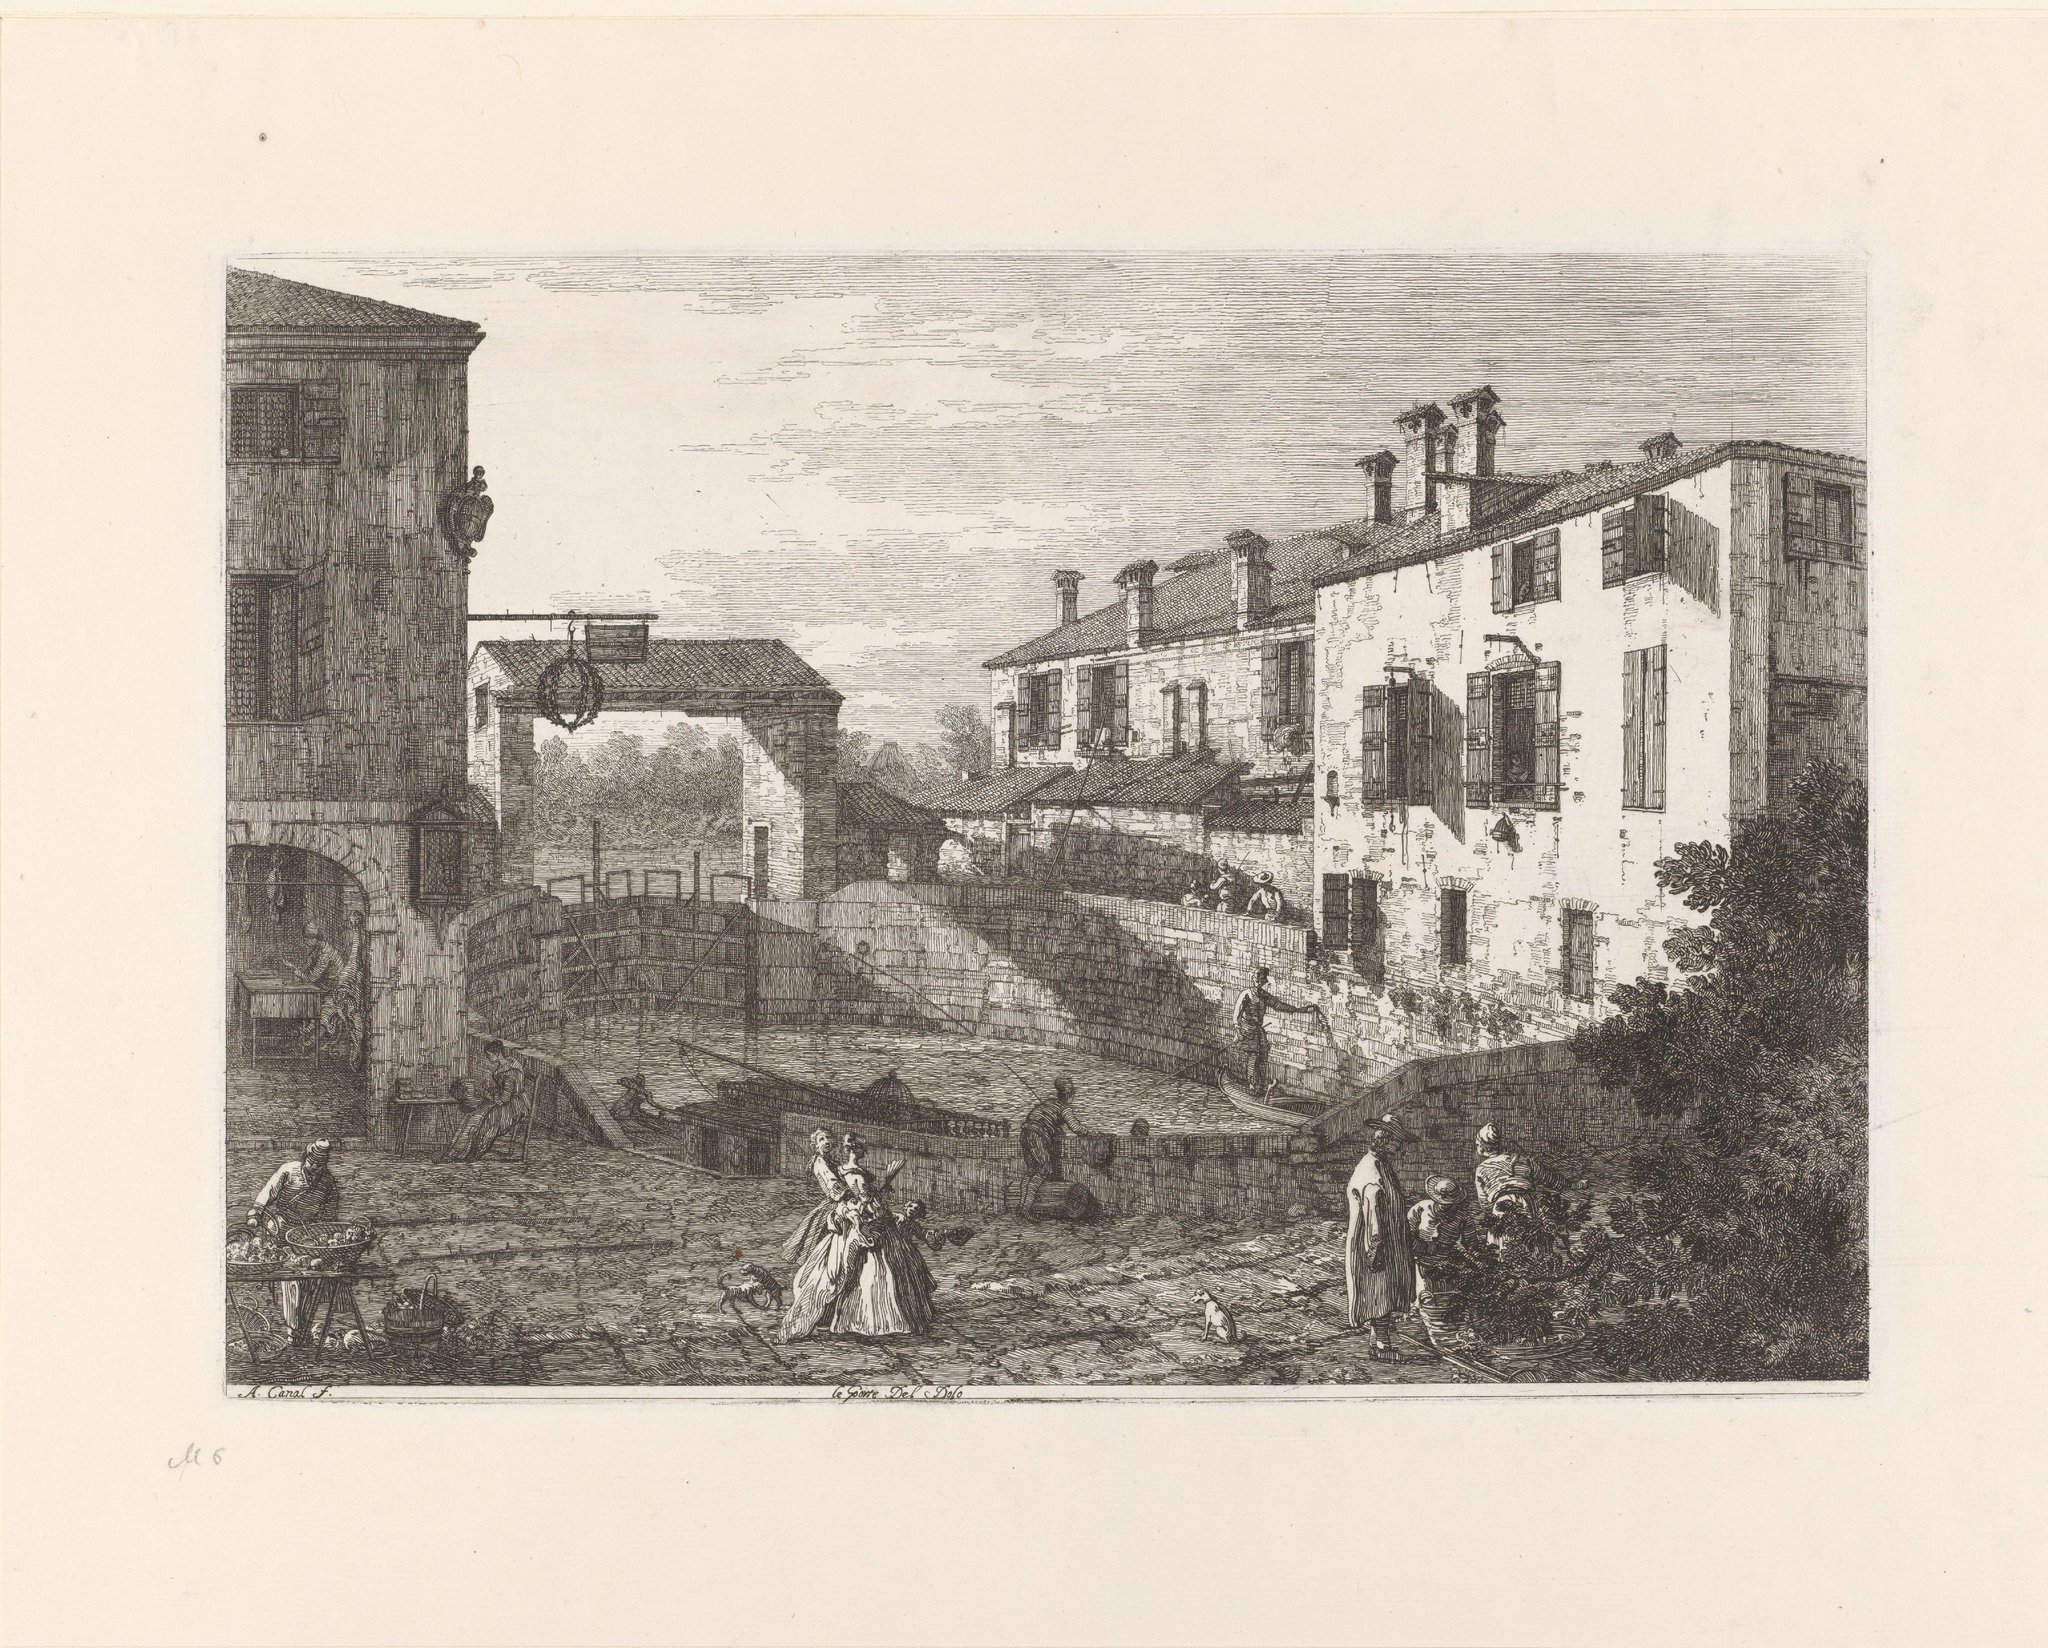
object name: print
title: Le porte del Dolo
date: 1707-1768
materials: paper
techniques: etching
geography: venice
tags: sluice, weir, street-trader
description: Een ovale sluis te Dolo. Over de ingang van de sluis een dak. Links een gebouw met wapenschild op de gevel. Een fruitverkoper en andere figuren op de voorgrond.